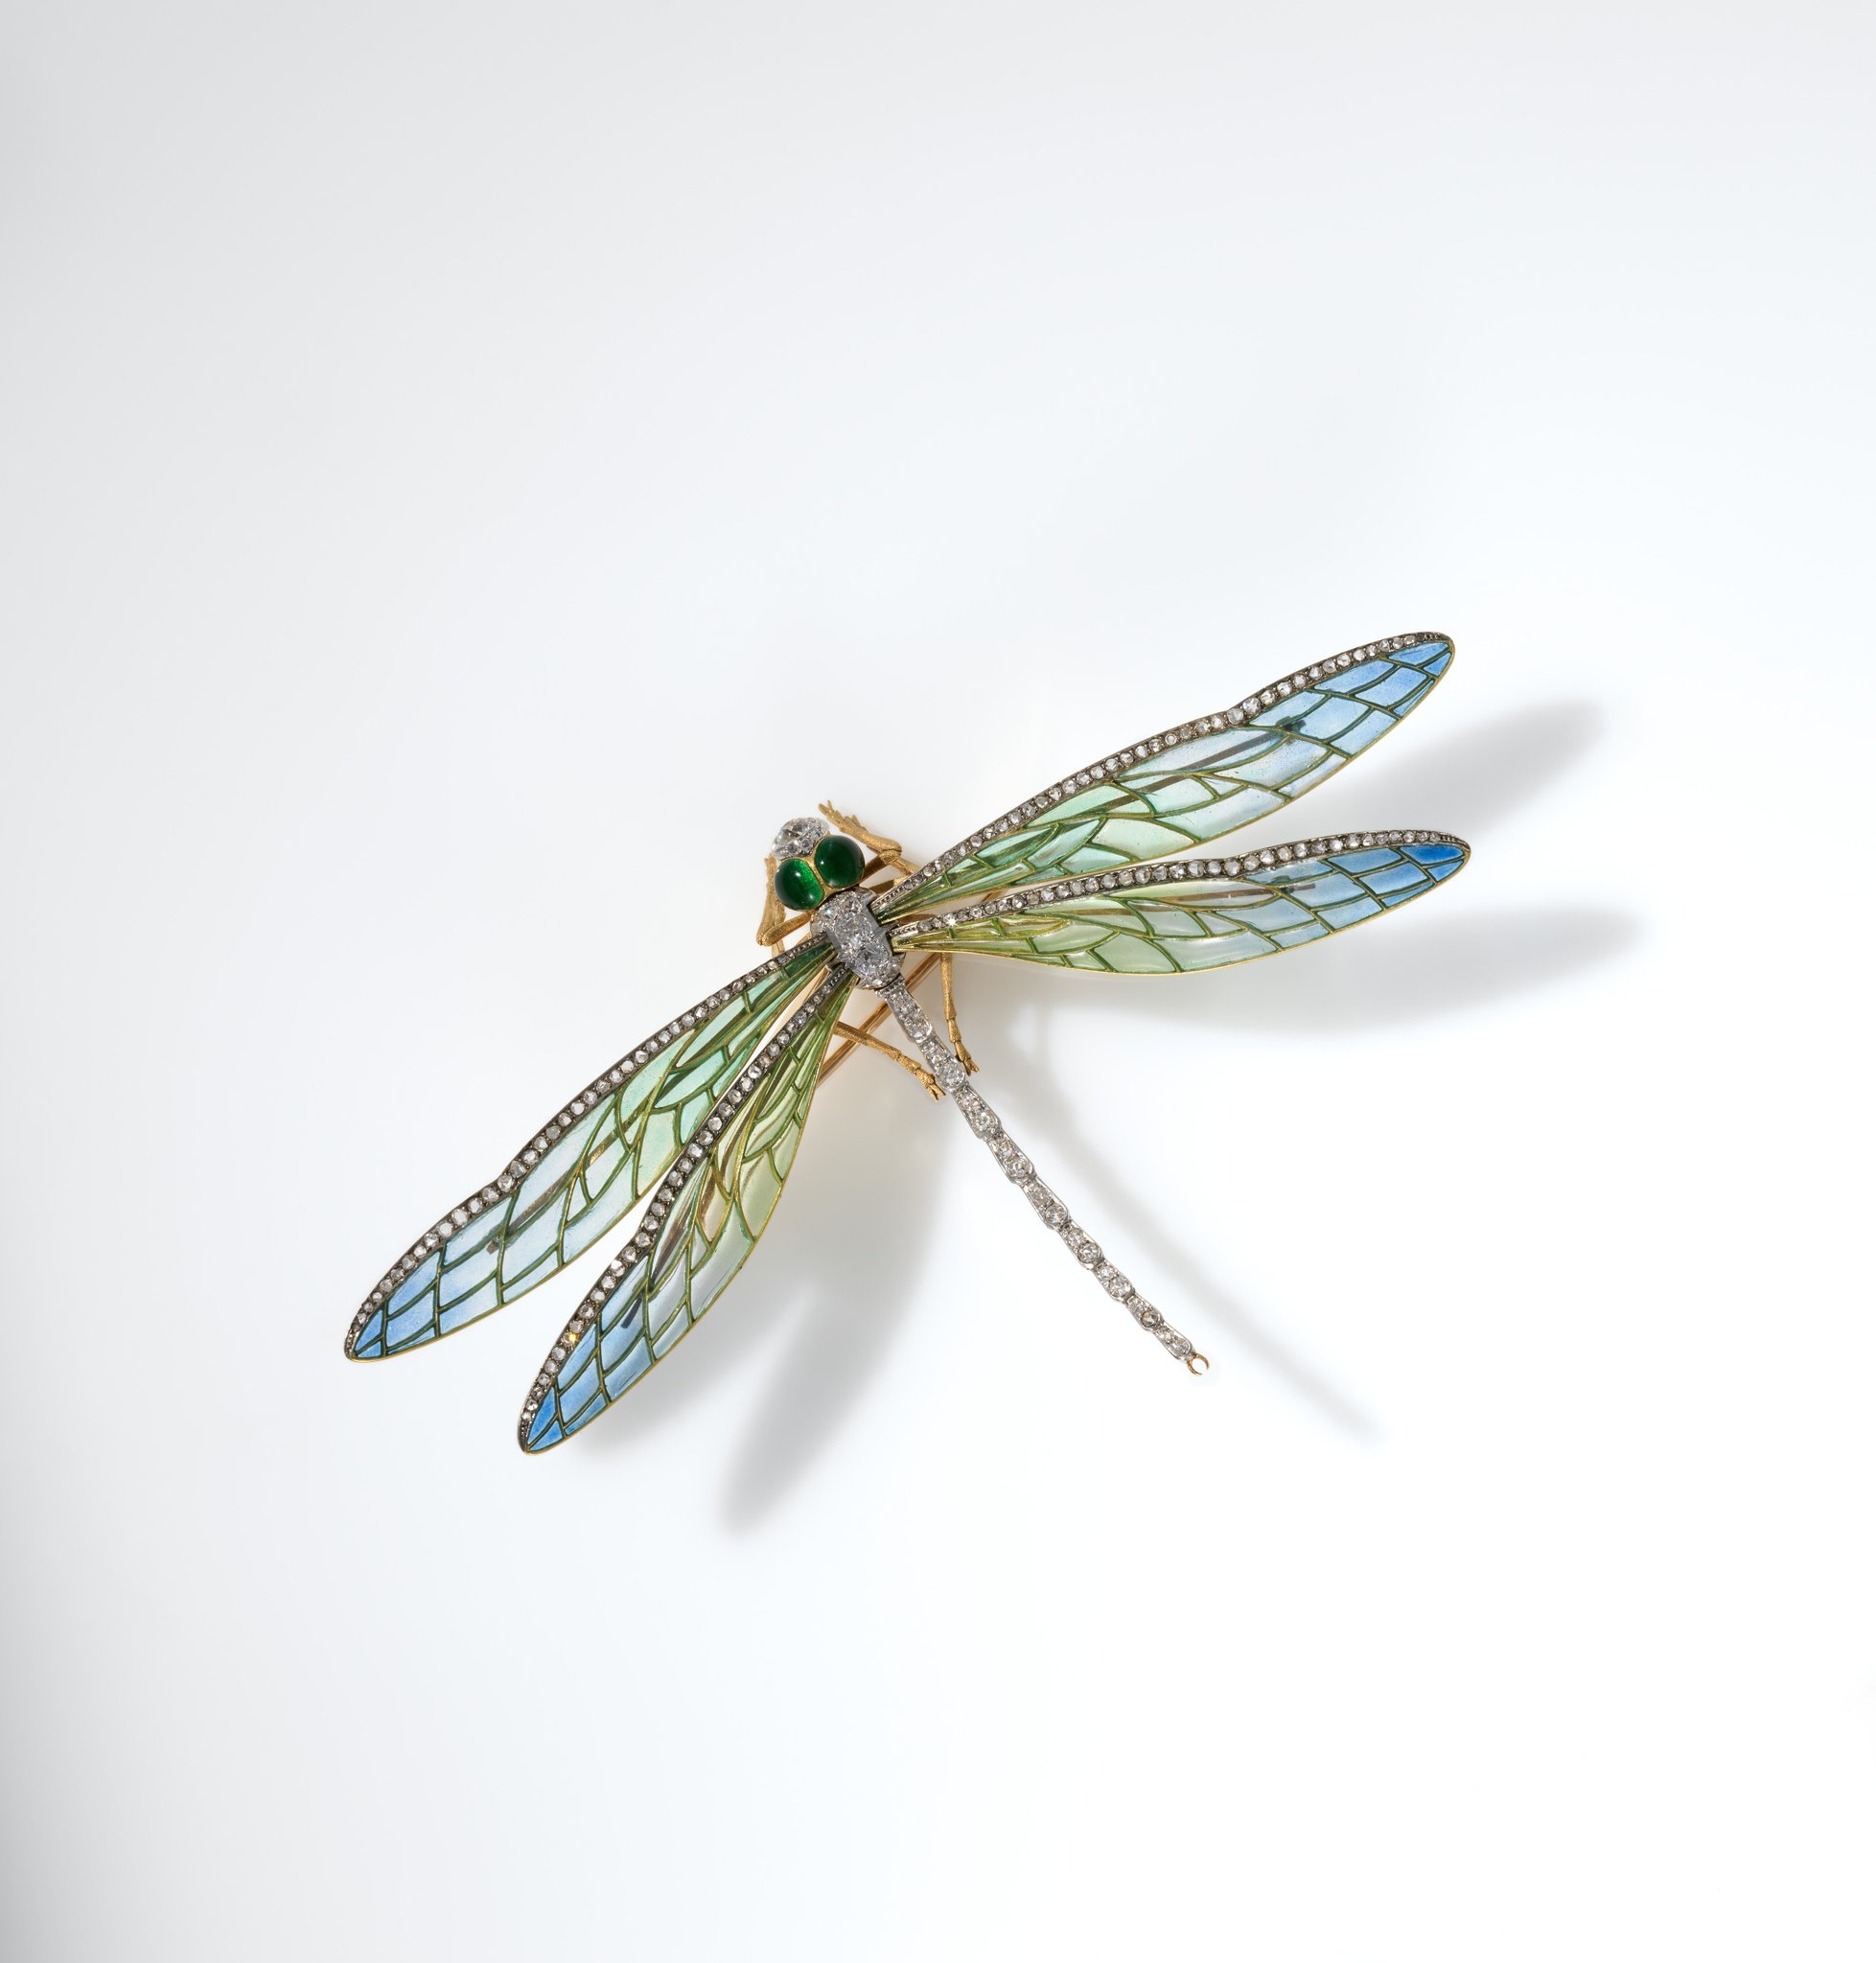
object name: brooch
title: Dragonfly brooch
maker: edgar bense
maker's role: maker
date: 1890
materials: diamond, enamel, gold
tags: dragonflies